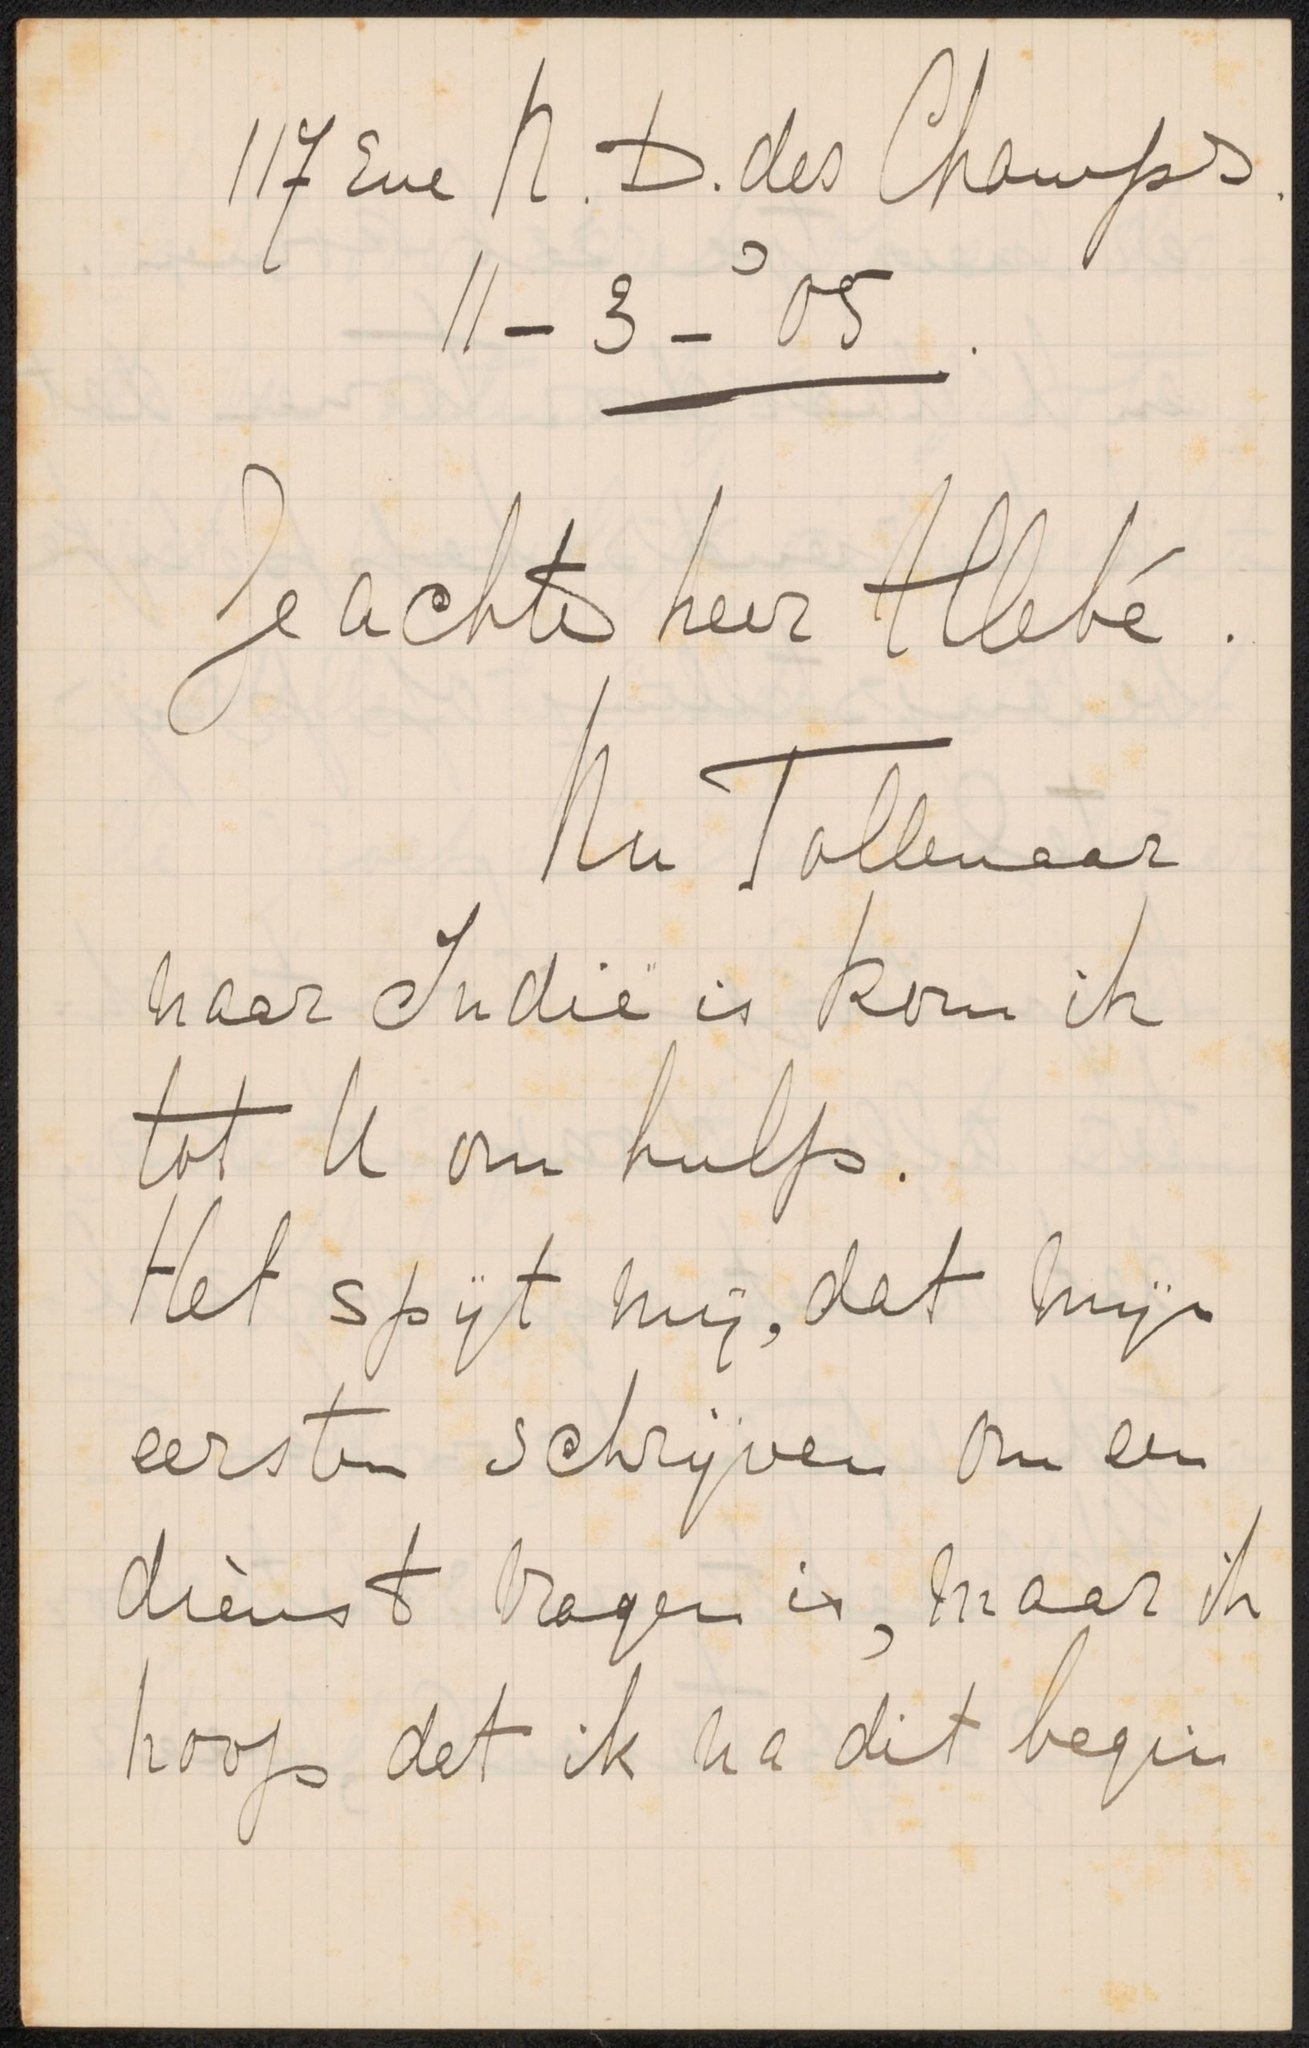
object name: letter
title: Brief aan August Allebé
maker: annie ermeling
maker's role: draughtsman, print maker, sculptor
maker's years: 1865-1932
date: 1905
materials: ink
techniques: pen, writing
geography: paris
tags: august allebé, maastricht, the hague, print maker, draughtsman, jonkheer victor eugène louis de stuers, artist's model, sitter, sculpture, painting (including book-illumination, miniature-painting), workshop, studio of the artist (in general), historical persons (portraits and scenes from the life), money